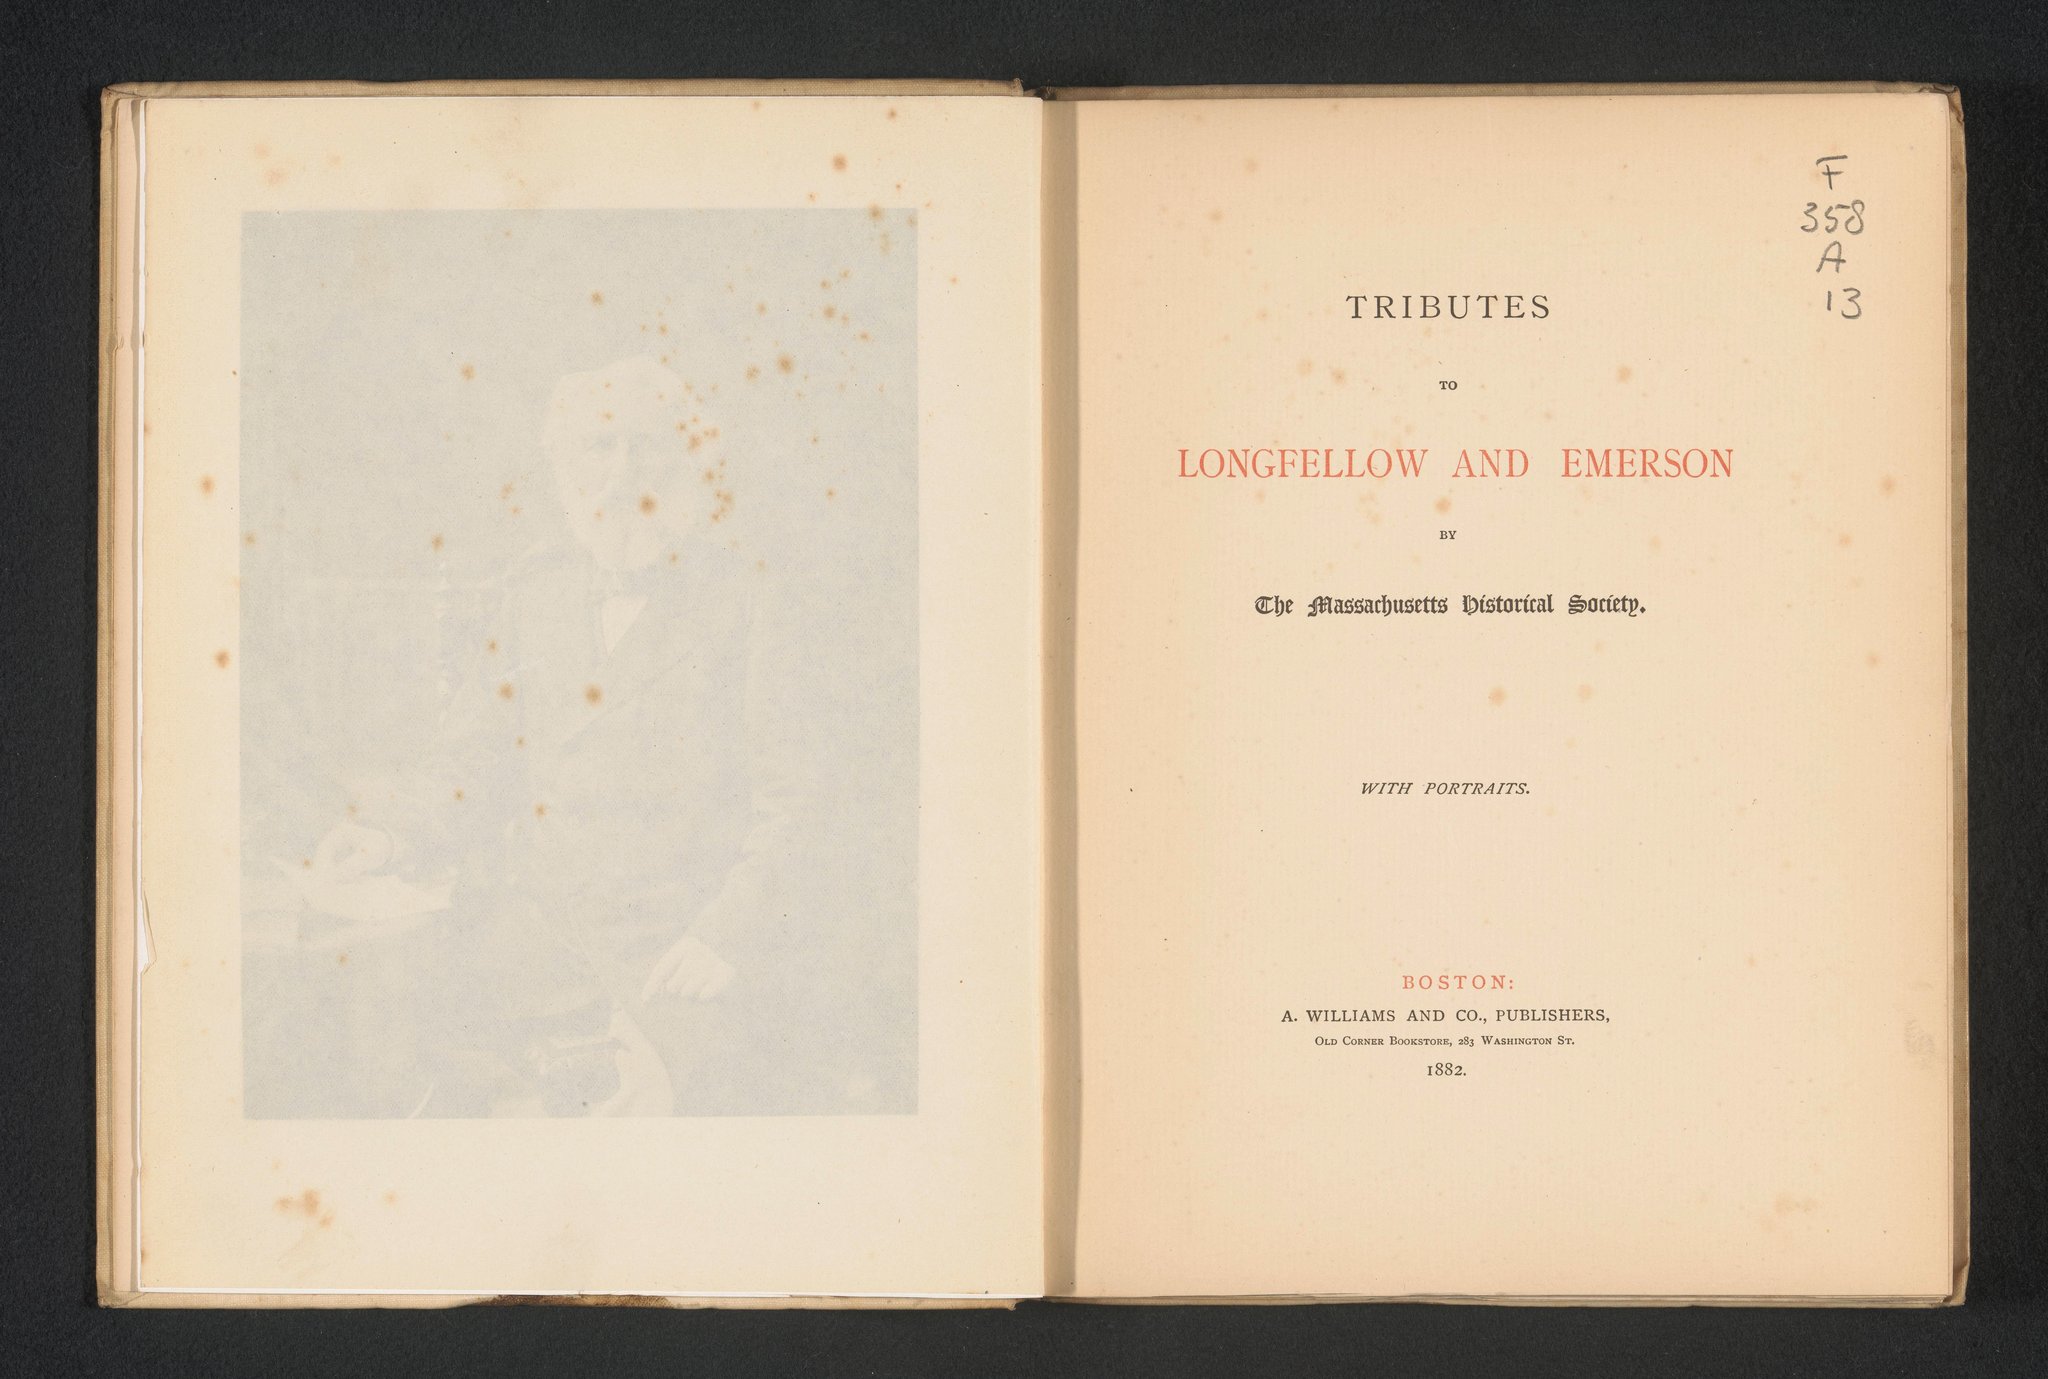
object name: book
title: Tributes to Longfellow and Emerson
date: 1882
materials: cardboard, paper, textile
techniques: photograph, printing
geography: boston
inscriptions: annotation: ‘The countess of Carnarvon/ from/ J.W. Palpray/ July 1. 1882’, annotation: ‘MAY/ 1986’